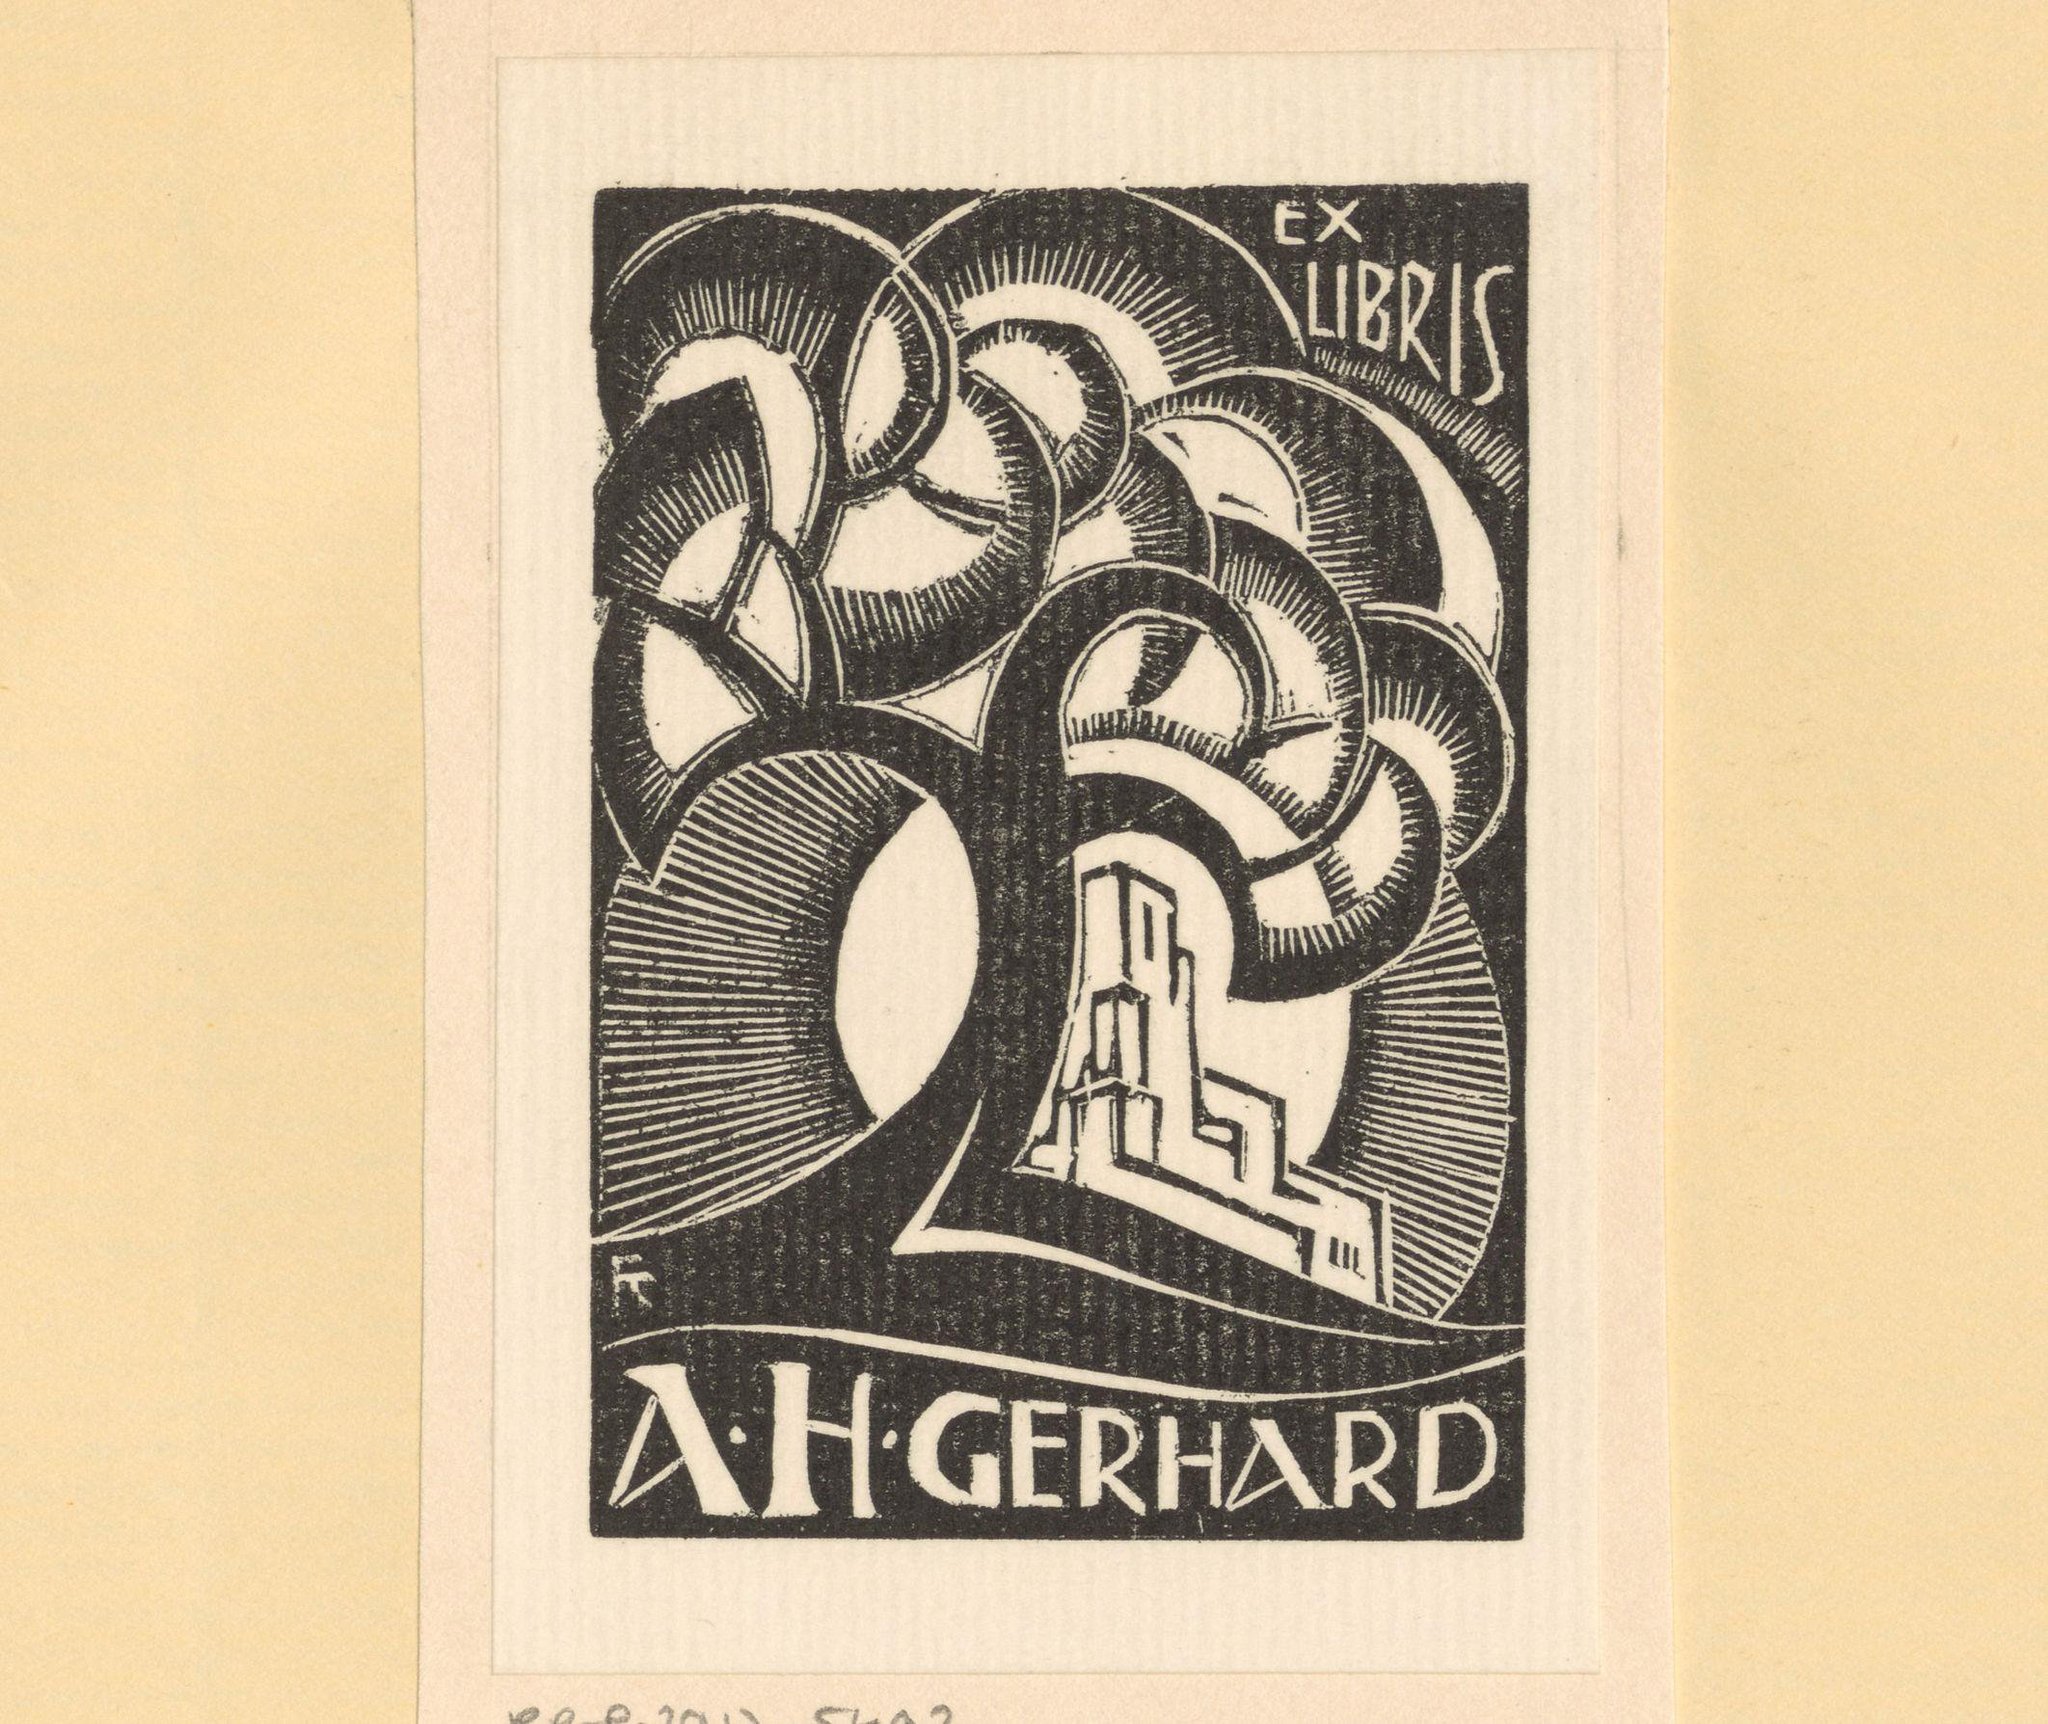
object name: bookplate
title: Ex libris van A.H. Gerhard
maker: fré cohen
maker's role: draughtsman, print maker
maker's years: 1903-1943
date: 1926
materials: paper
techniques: woodcut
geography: netherlands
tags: trees, housing, sun as celestial body